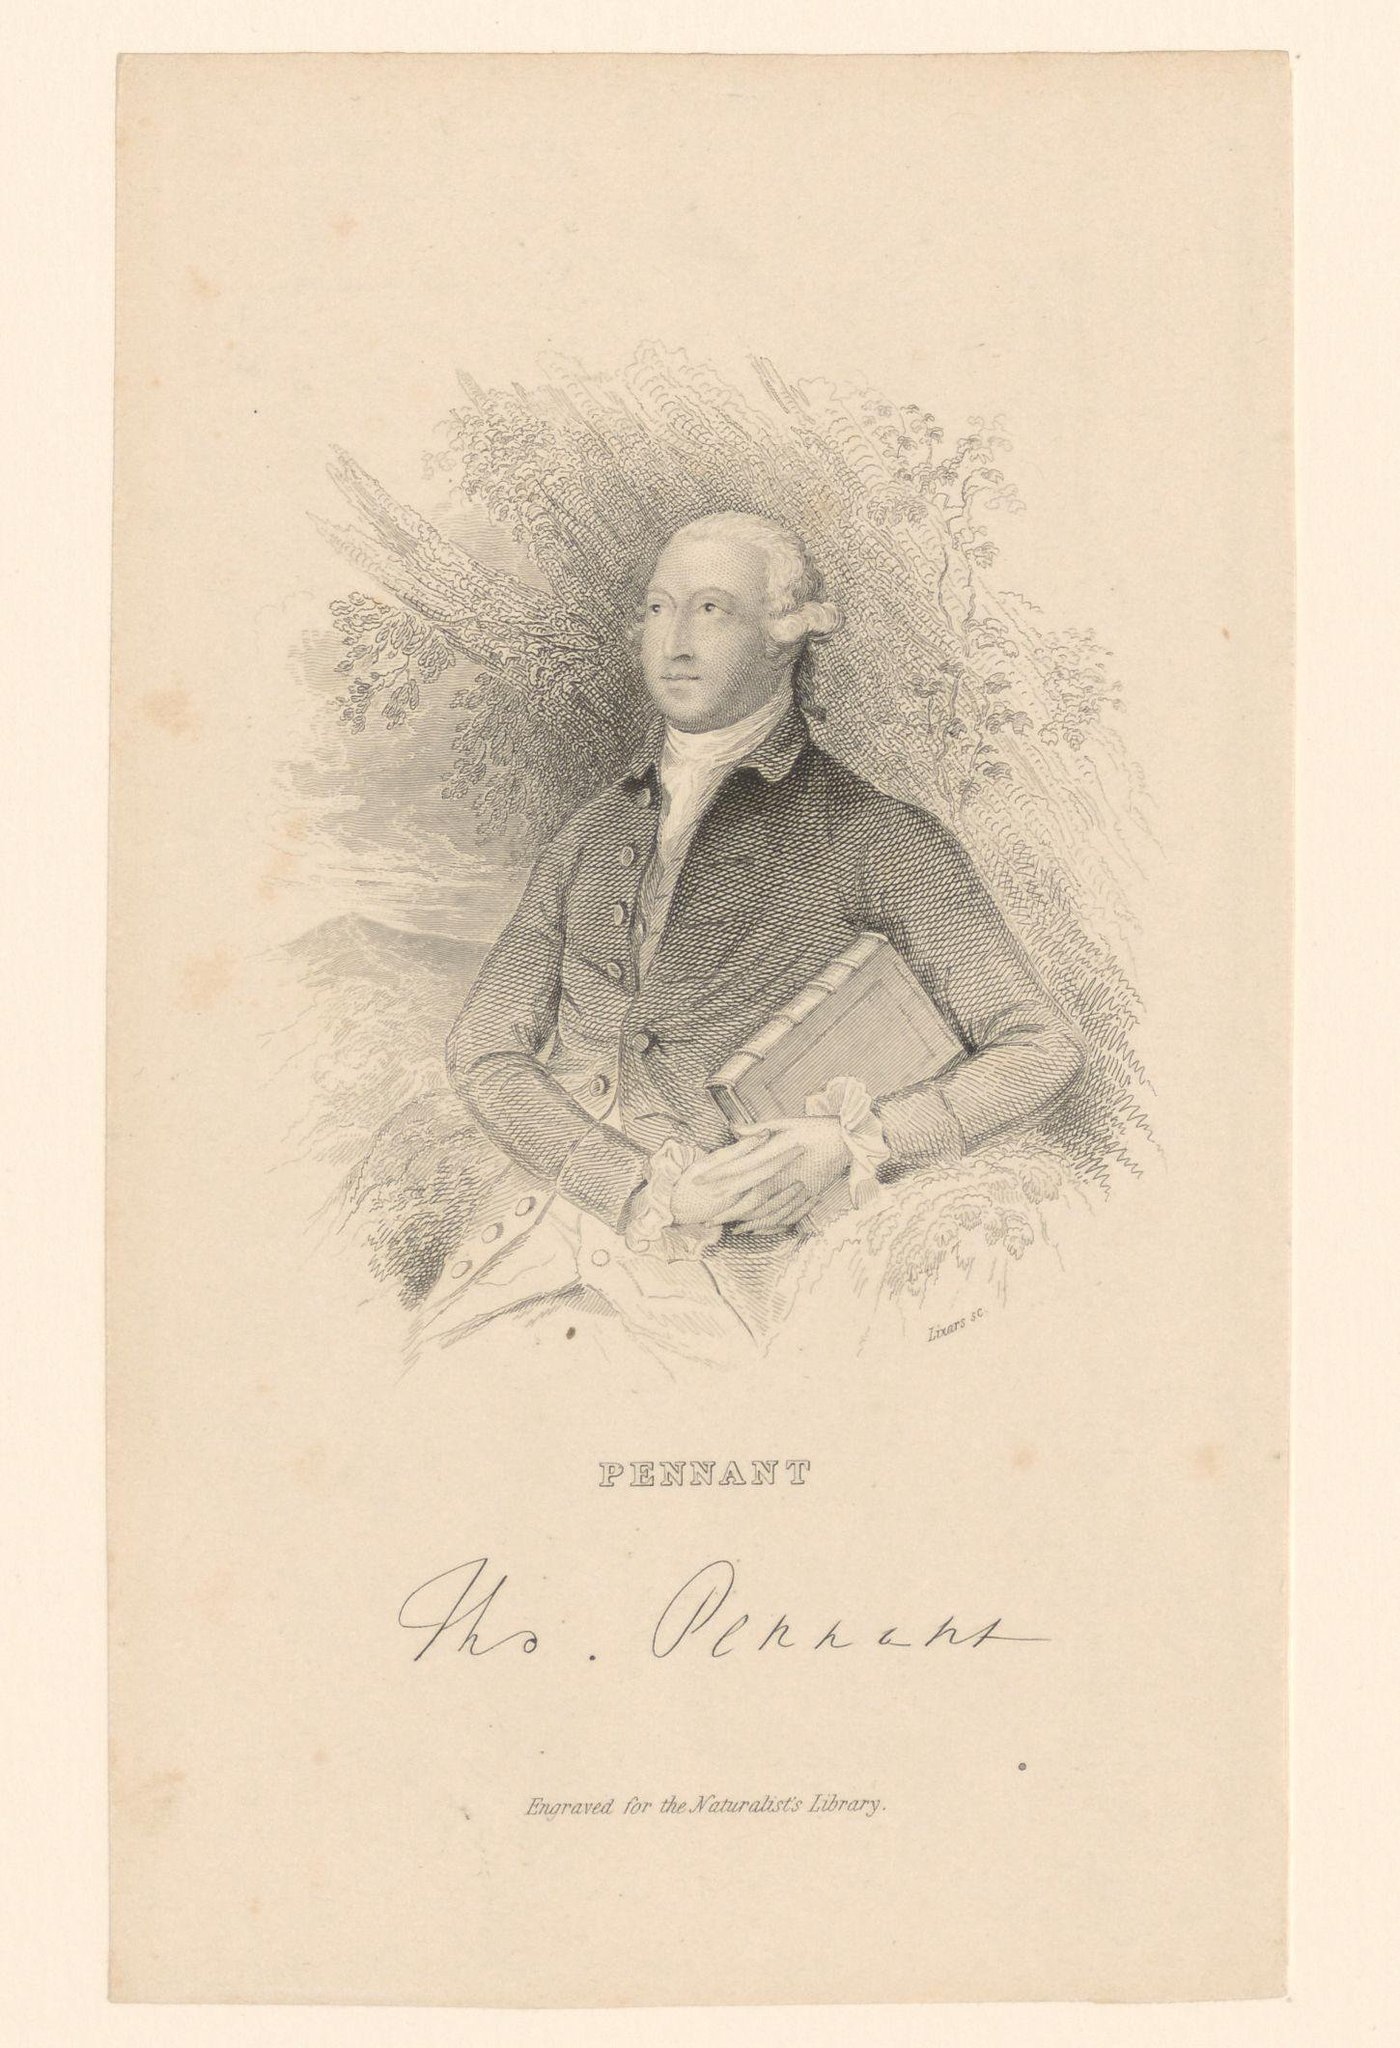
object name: print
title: Portret van Thomas Pennant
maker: william home lizars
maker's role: print maker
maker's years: 1788-1859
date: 1798-1859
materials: paper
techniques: engraving, etching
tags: botany (+ portrait of scholar, scientist), historical persons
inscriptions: collector's mark: Lugt 2228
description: Een facsimile signatuur in de ondermarge.